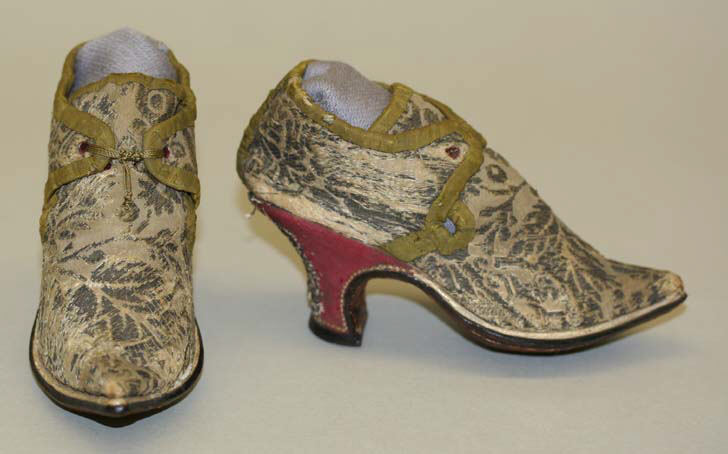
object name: shoe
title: Shoes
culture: french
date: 1701-1800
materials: silk